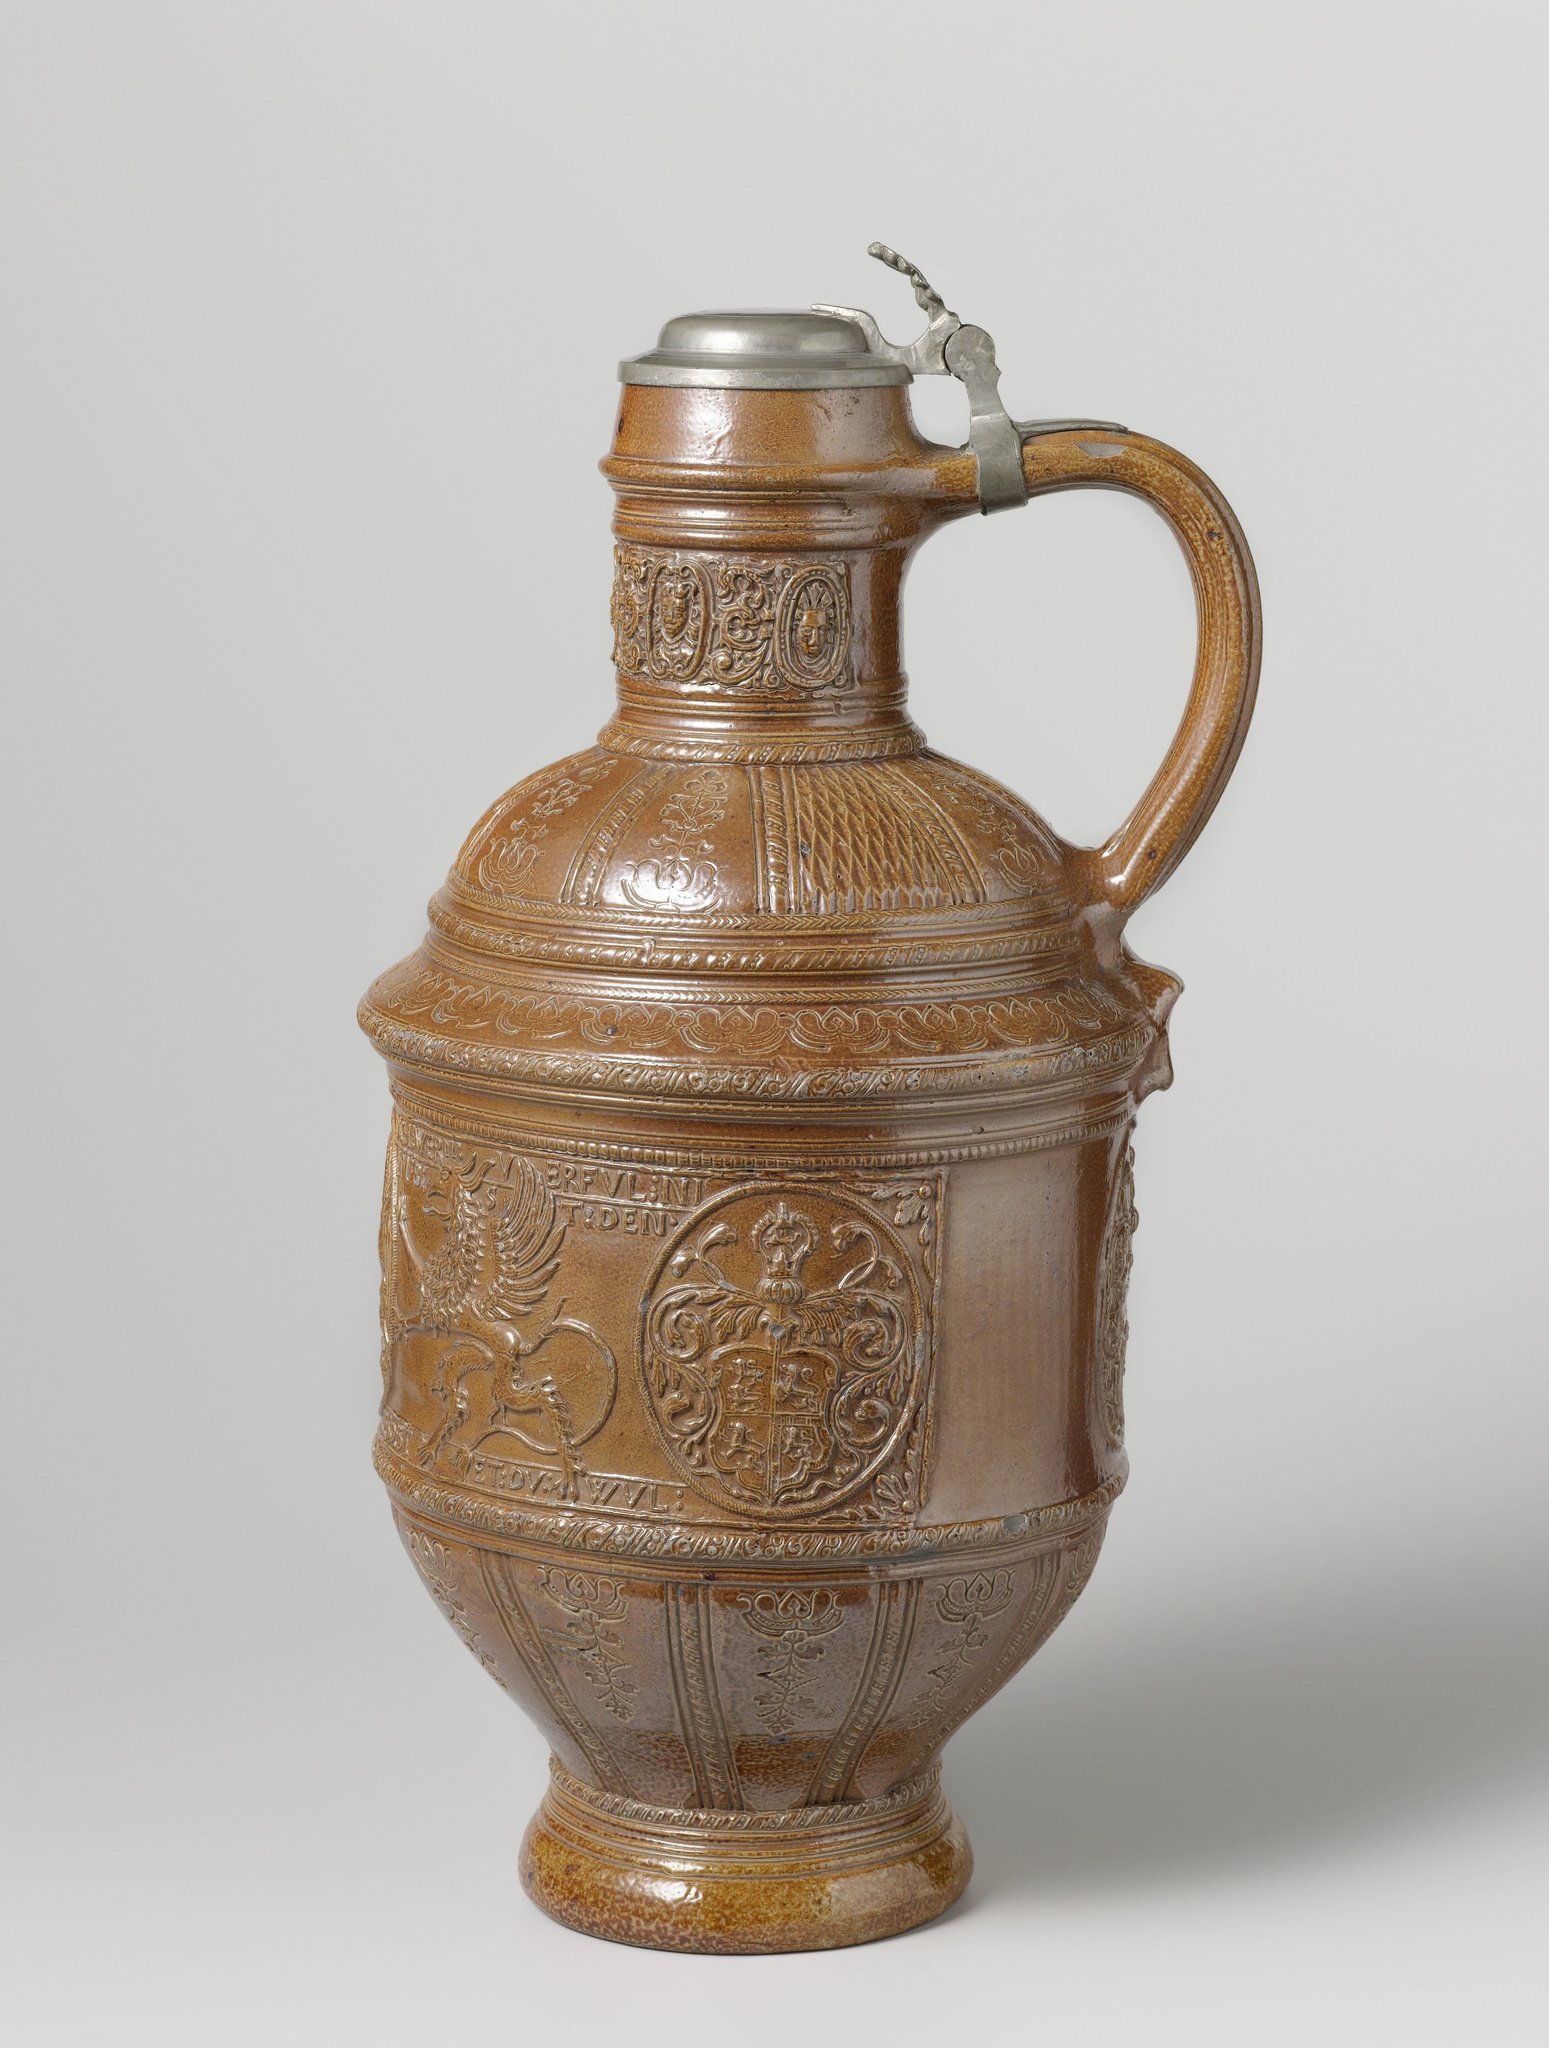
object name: jug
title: Jug with the arms of Saxony and Brunswick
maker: jan baldems mennicken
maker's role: potter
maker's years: 1568-1612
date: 1599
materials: engobe, glaze, stoneware, tin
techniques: printing, firing, forming, relief, turning, vitrification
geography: raeren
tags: armorial bearing, heraldry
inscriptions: inscription: ‘IVGER GESEL HALT DICH WERM VERFVL NIT DEINEN DRIM BIST DEN FRVWEN NIT SV HVLT SO STET DV WVL’, date: ‘1599’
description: Kruik van steengoed op hoge voet met een cilindervormig lichaam met ronde, iets smallere schouder en wijde nek. Het C-vormige oor is bevestigd aan de nek en de schouder. Profielen op de nek, buik en voet. Bedekt met een bruin engobe. Op de buik in reliëf een gedrukte en opgelegde band met medaillons. Het middelste medaillon met een pelikaan die de jongen uit haar eigen borst voedt, geflankeerd door griffioenen. De twee andere medaillons bevatten de wapens van Saksen en van Brunswijk. Tussen de medaillons het opschrift 'IVGER GESEL HALT DICH WERM VERFVL NIT DEINEN DRIM BIST DEN FRVWEN NIT SV HVLT SO STET DV WVL' en de datum '1599'. Het onderste deel van de buik loopt schuin af naar de voet en is verdeeld in ingegrifte vakken met een gestempelde bloemtak. De schouder met dezelfde decoratie, maar hier is de bloemtak afgewisseld met kerfsnede. Op de nek een band met bladranken onderbroken door maskers in medaillons. Bevestigd aan het oor een tinnen montuur met deksel. Raeren.